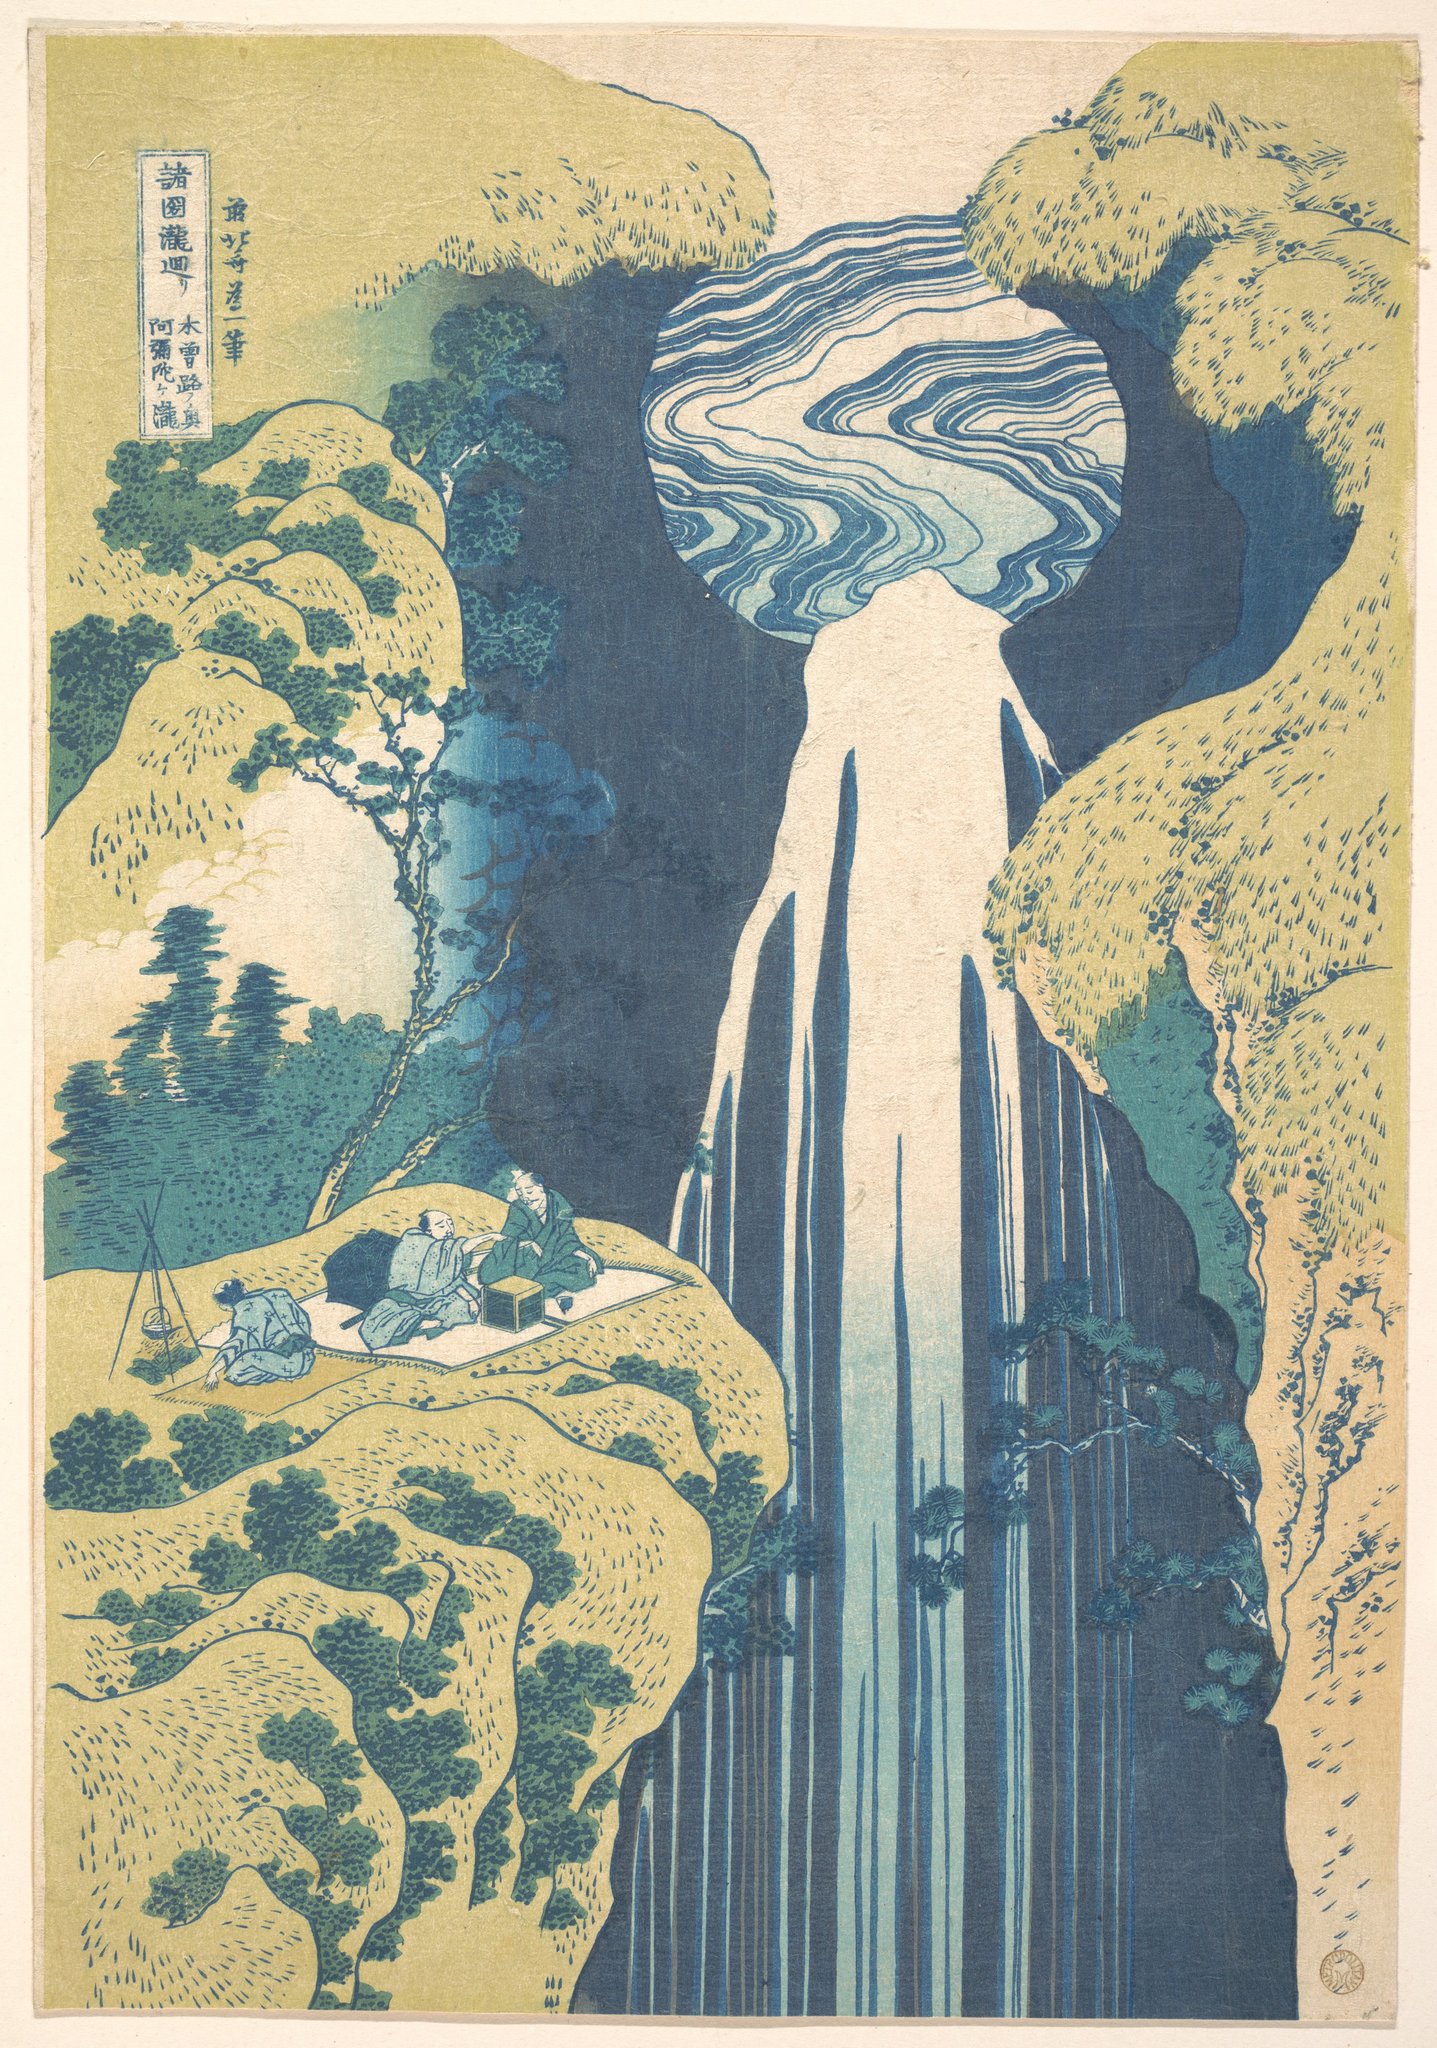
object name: woodblock print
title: The Amida Falls in the Far Reaches of the Kisokaidō Road (Kisoji no oku Amida-ga-taki), from the series A Tour of Waterfalls in Various Provinces (Shokoku taki meguri)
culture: japanese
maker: katsushika hokusai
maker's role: artist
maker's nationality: japanese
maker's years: 1760-1849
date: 1827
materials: ink, paper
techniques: woodblock print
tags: human figures,waterfalls,mountains,trees